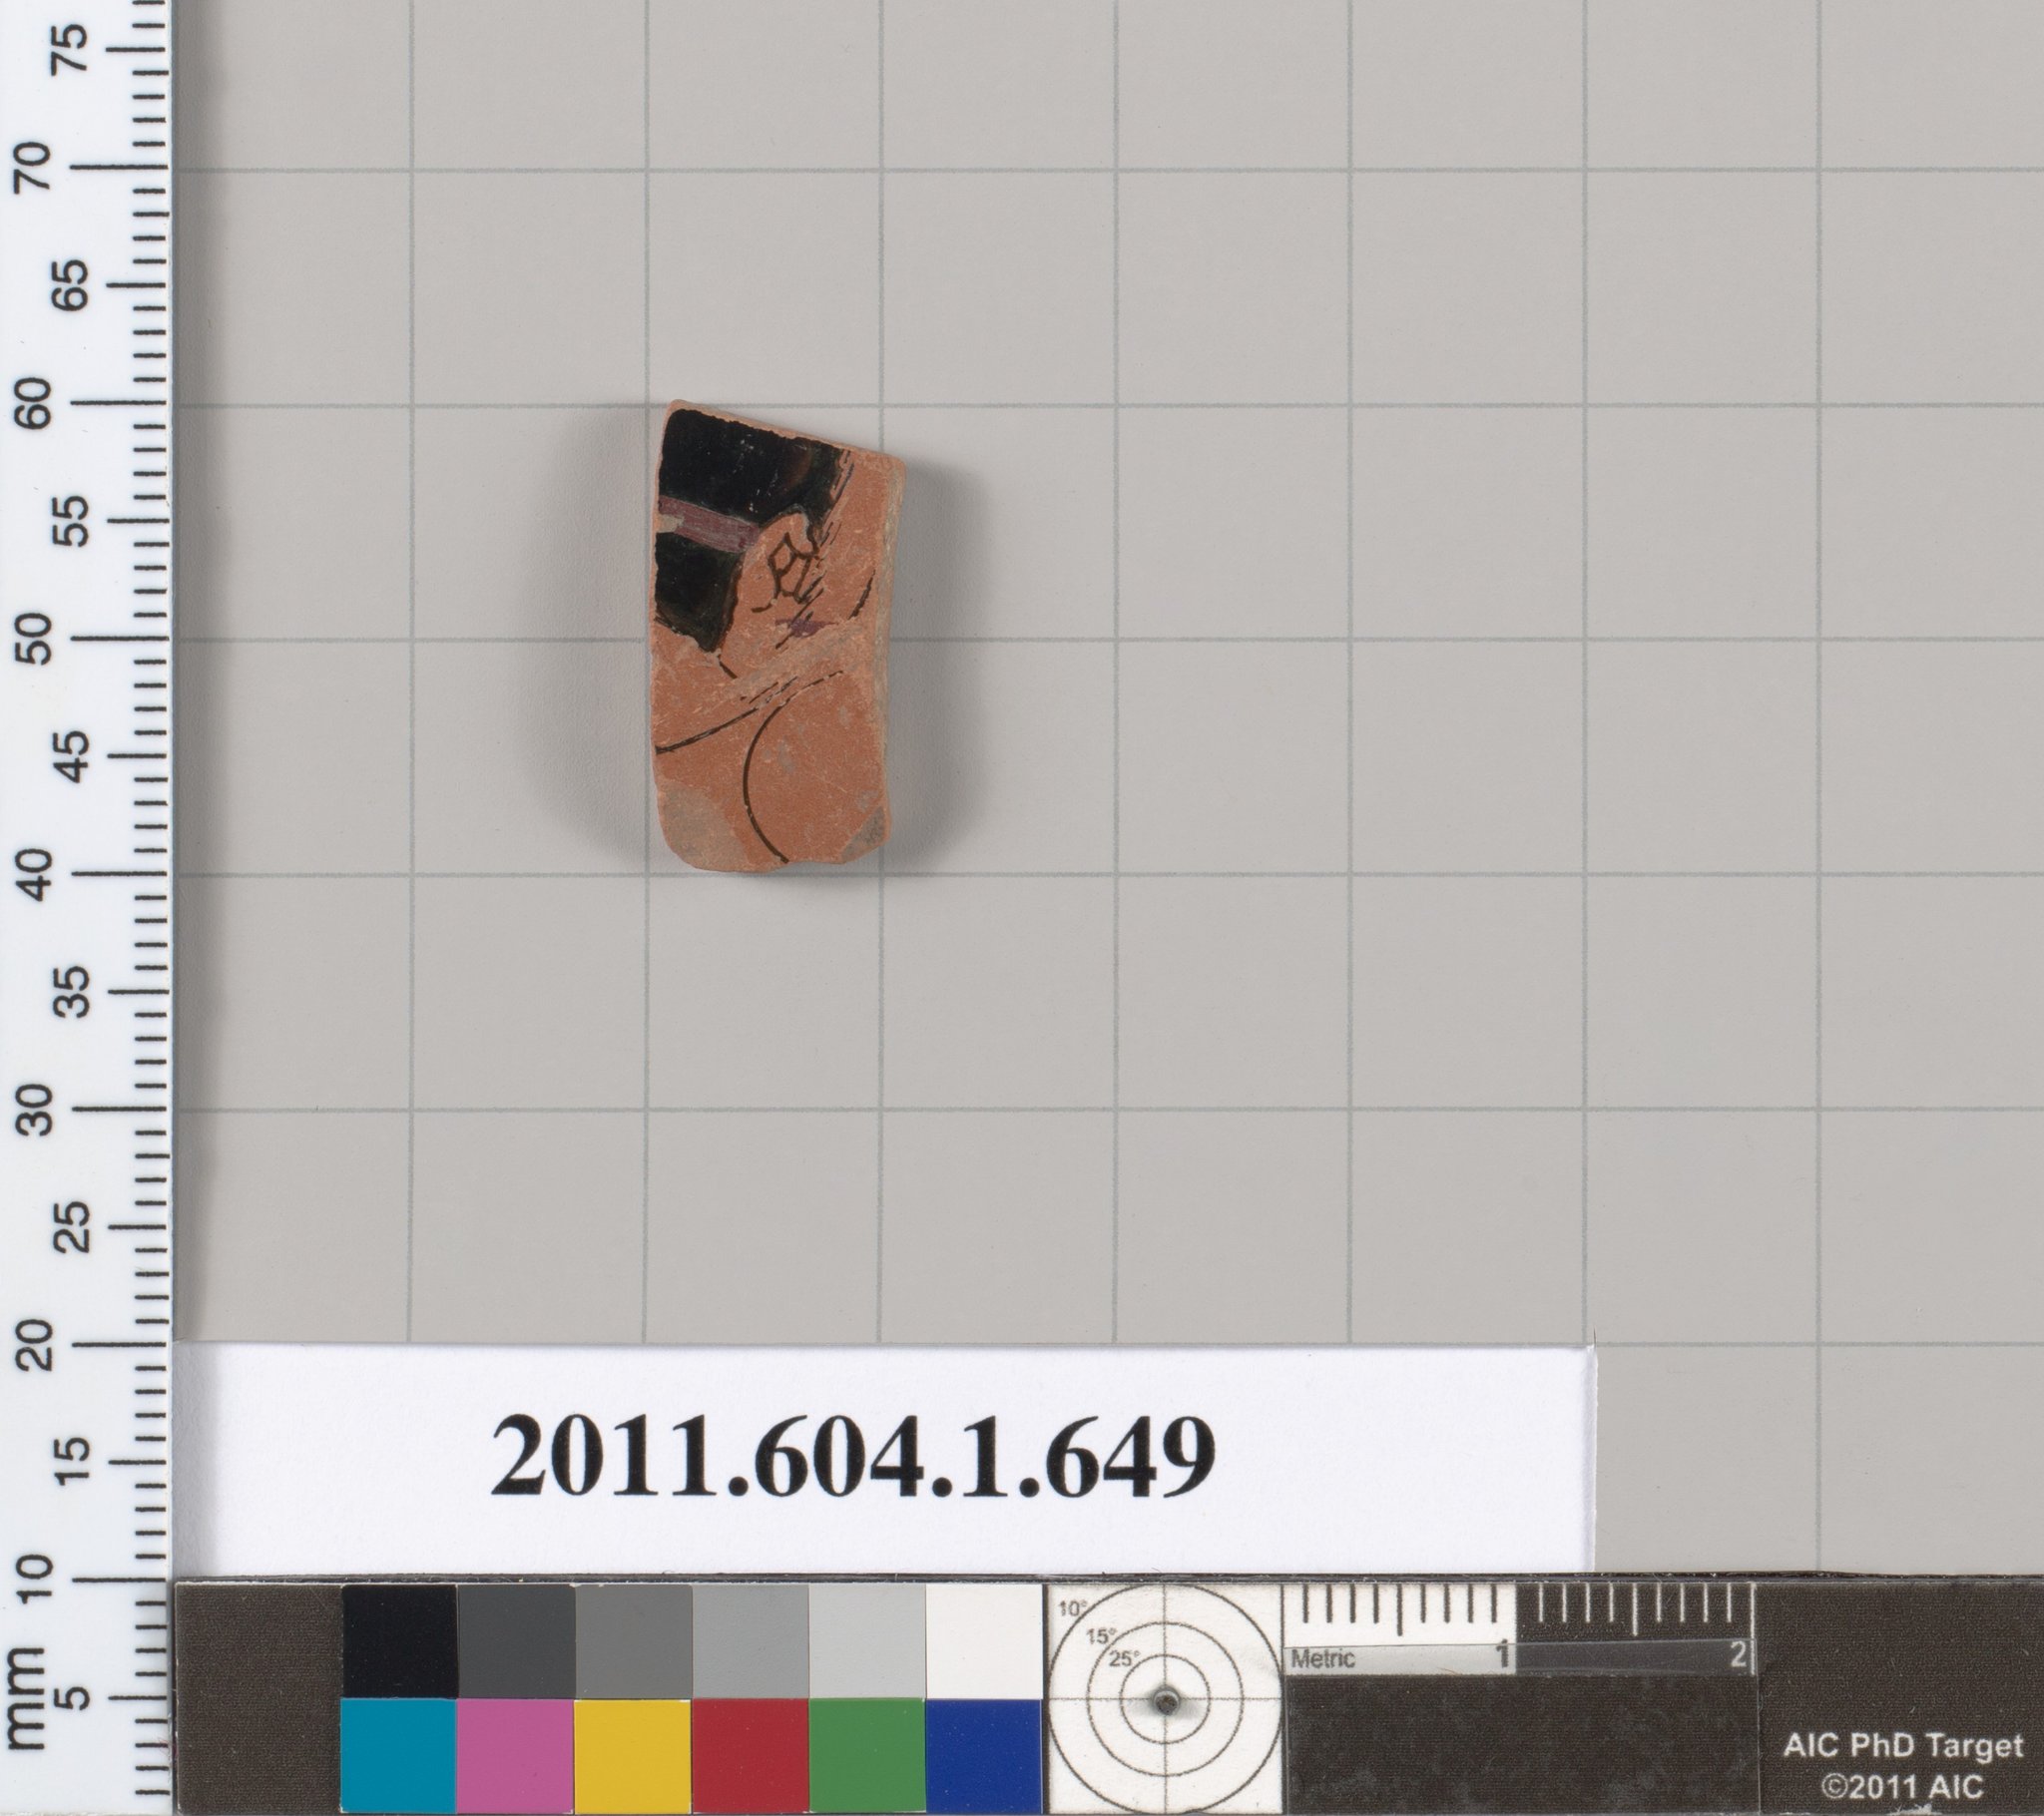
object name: kylix fragment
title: Terracotta fragment of a kylix (drinking cup)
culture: greek, attic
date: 475-451 BCE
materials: terracotta